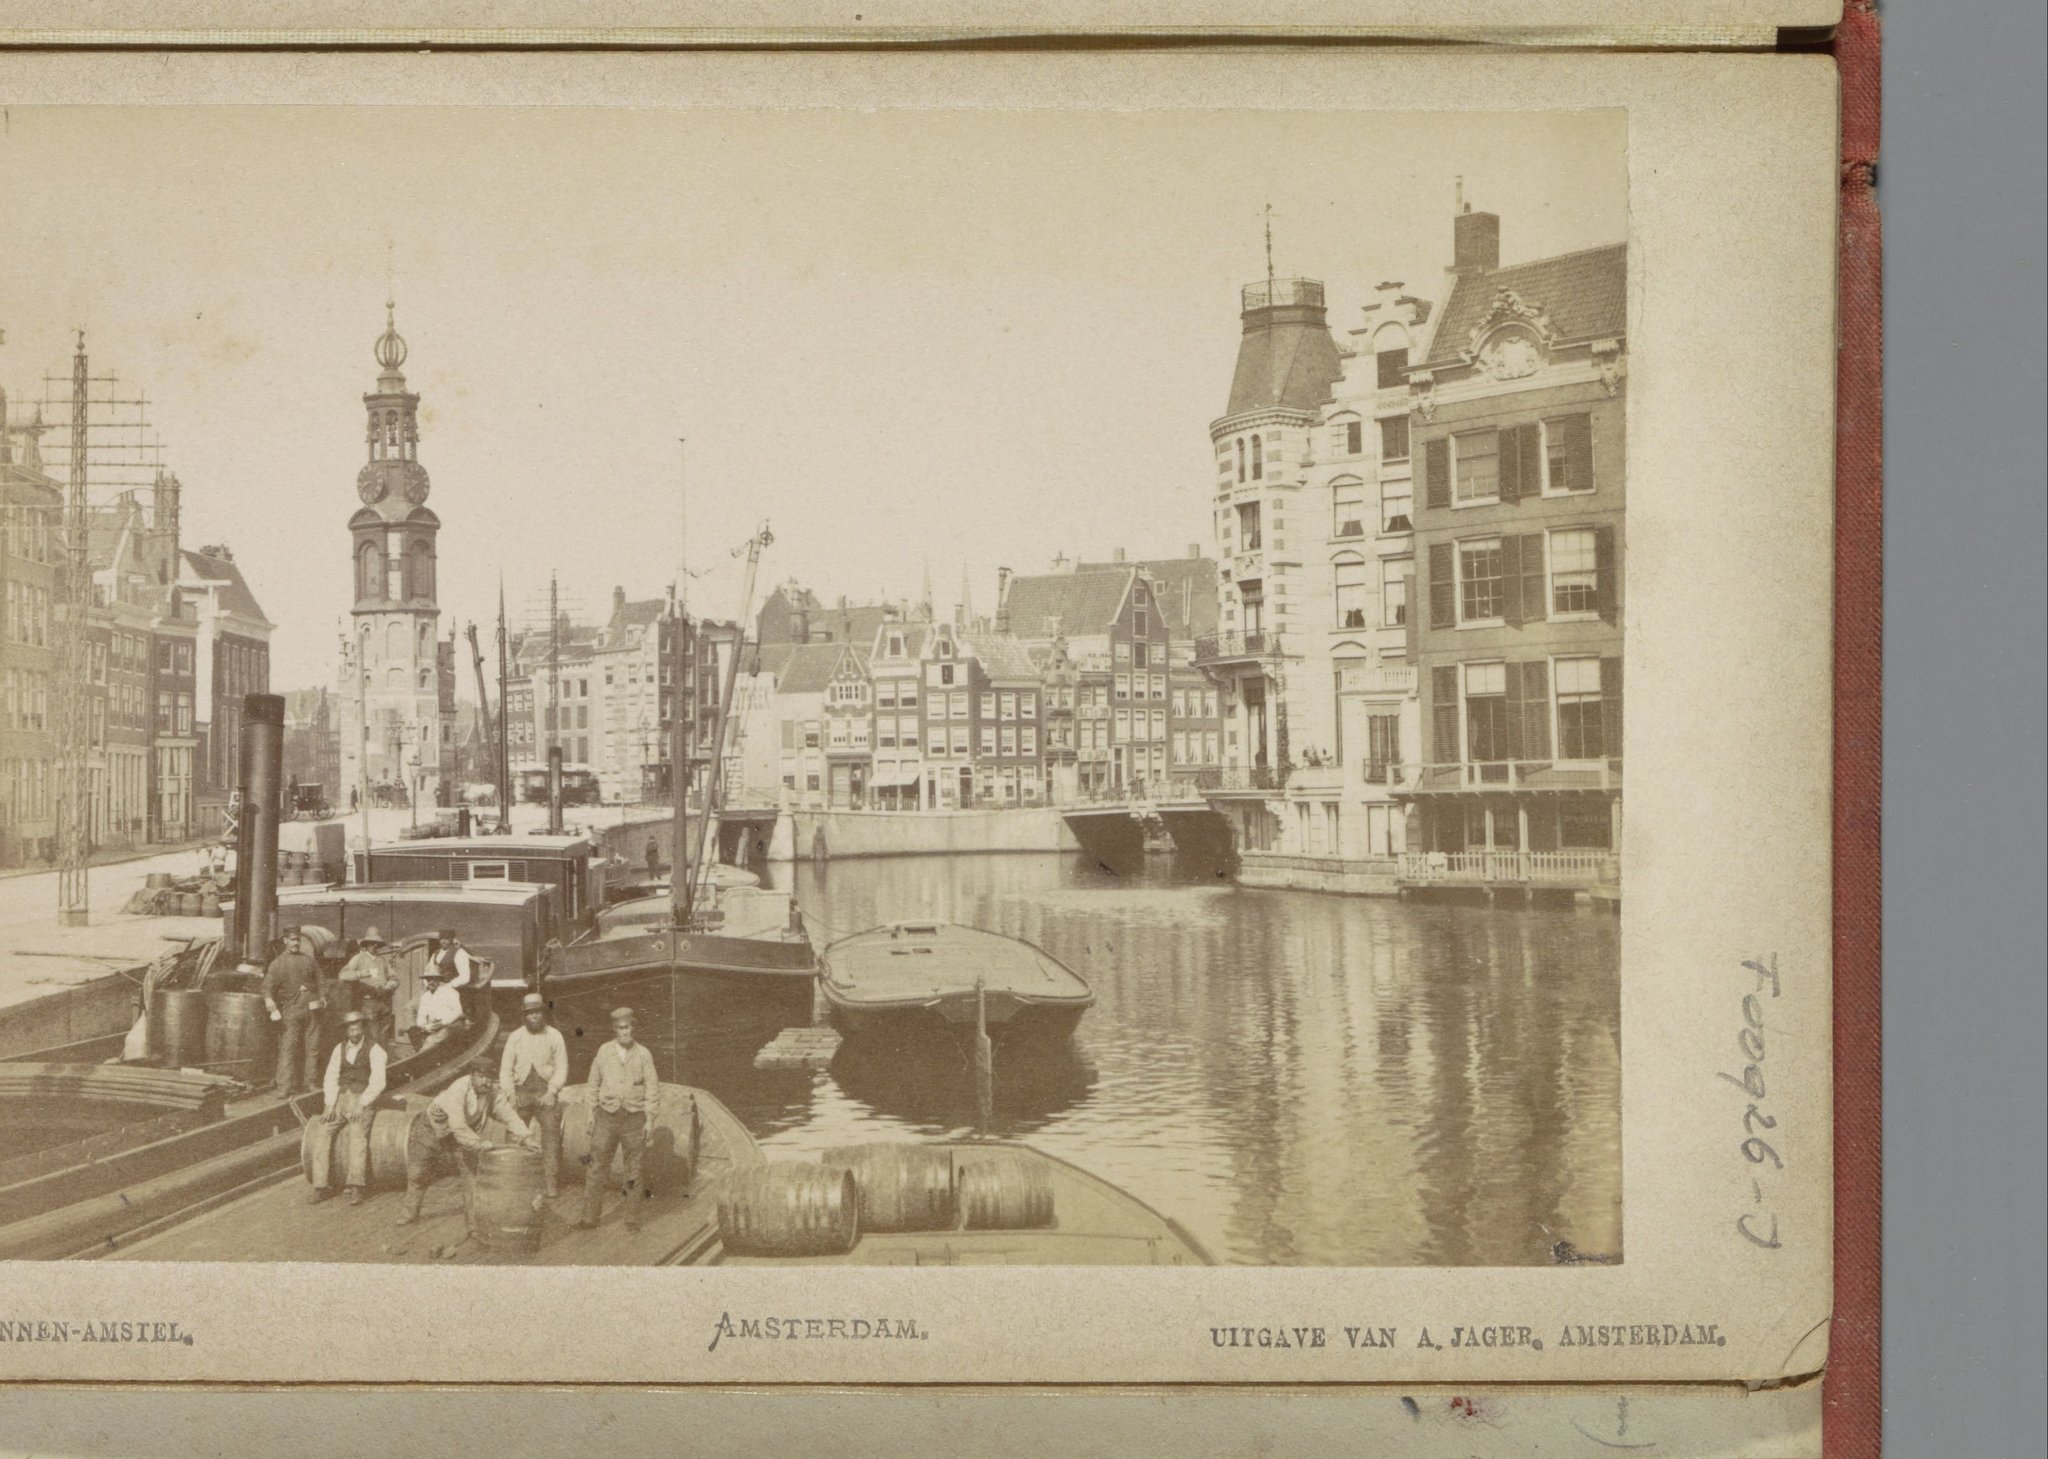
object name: cabinet photograph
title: Gezicht op de Binnen-Amstel richting de Munttoren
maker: andries jager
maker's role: publisher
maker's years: 1825-1905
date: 1860-1900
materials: cardboard, photographic support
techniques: albumen print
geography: amsterdam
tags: towers ~ fortified city, canal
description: Onderdeel van Leporelloalbum met 12 foto's van Amsterdam.